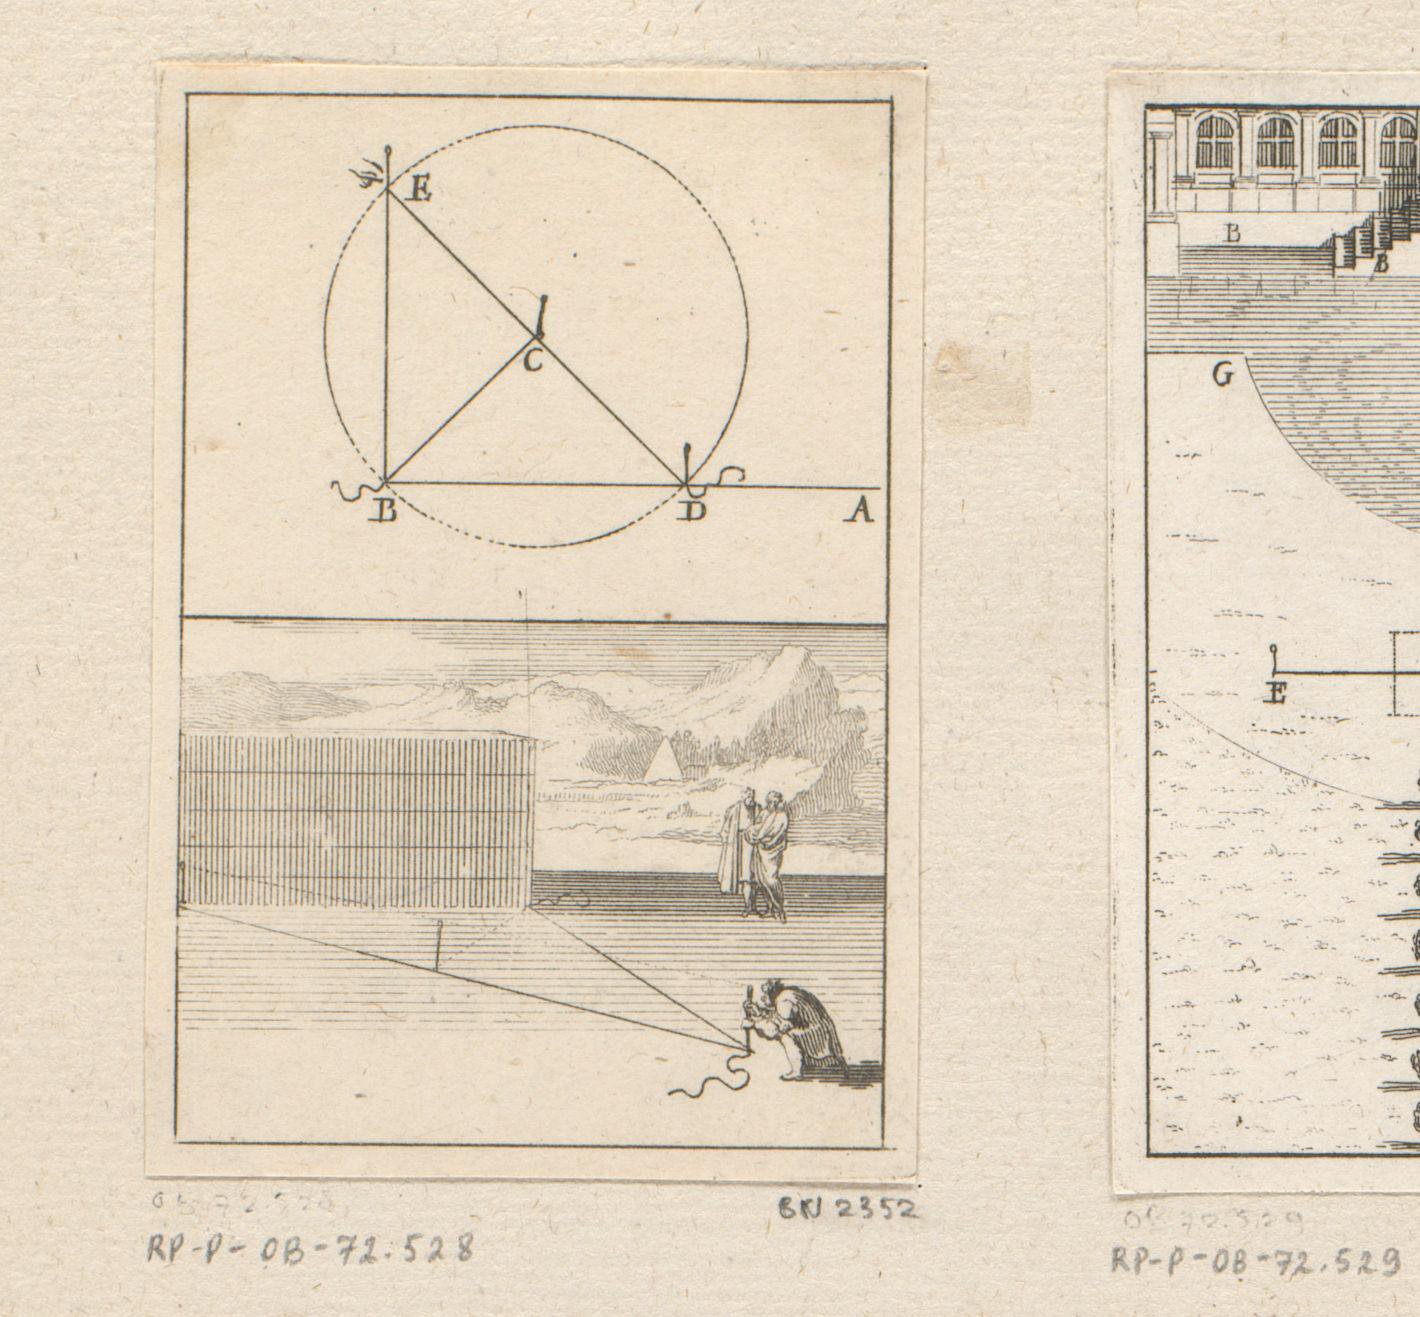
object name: book illustration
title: Trekken van een lijn die een rechte hoek maakt met een muur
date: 1669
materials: paper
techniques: etching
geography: france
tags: fence, wall, paling, planimetry, geometry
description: Prent toegevoegd aan: Pratique de la géometrie, sur le papier et sur le terrain. Avec un nouvel ordre et une méthode particulière. Parijs: Thomas Jolly, 1669.